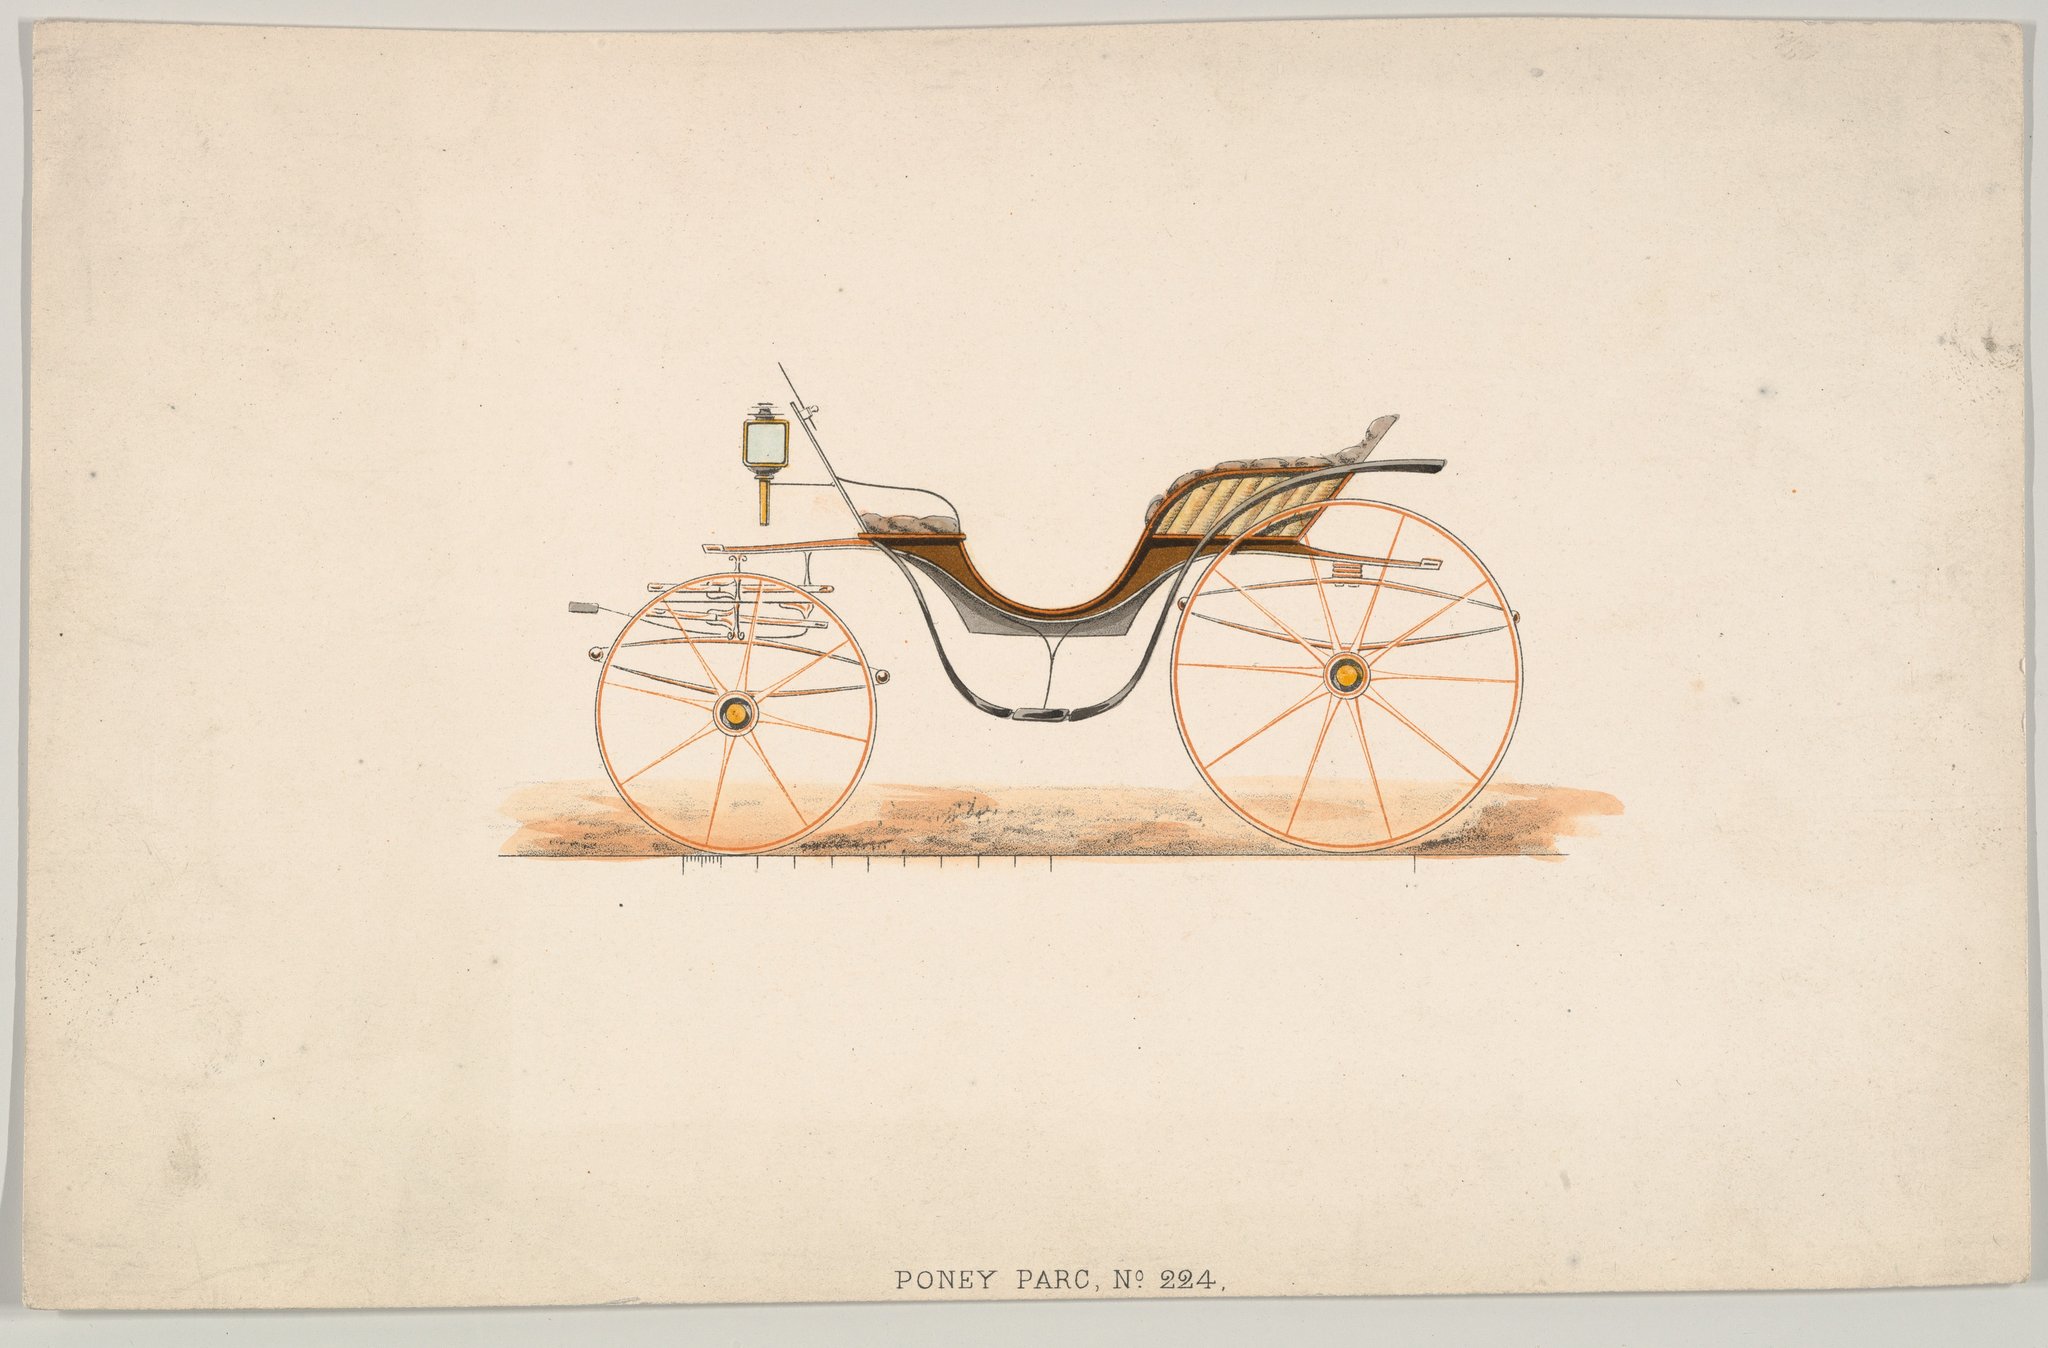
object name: print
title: Design for Pony Phaeton, no. 224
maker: anonymous, french, 19th century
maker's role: artist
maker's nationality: french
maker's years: 1800-1900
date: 1870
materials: gum arabic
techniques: hand coloring, lithograph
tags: carriages